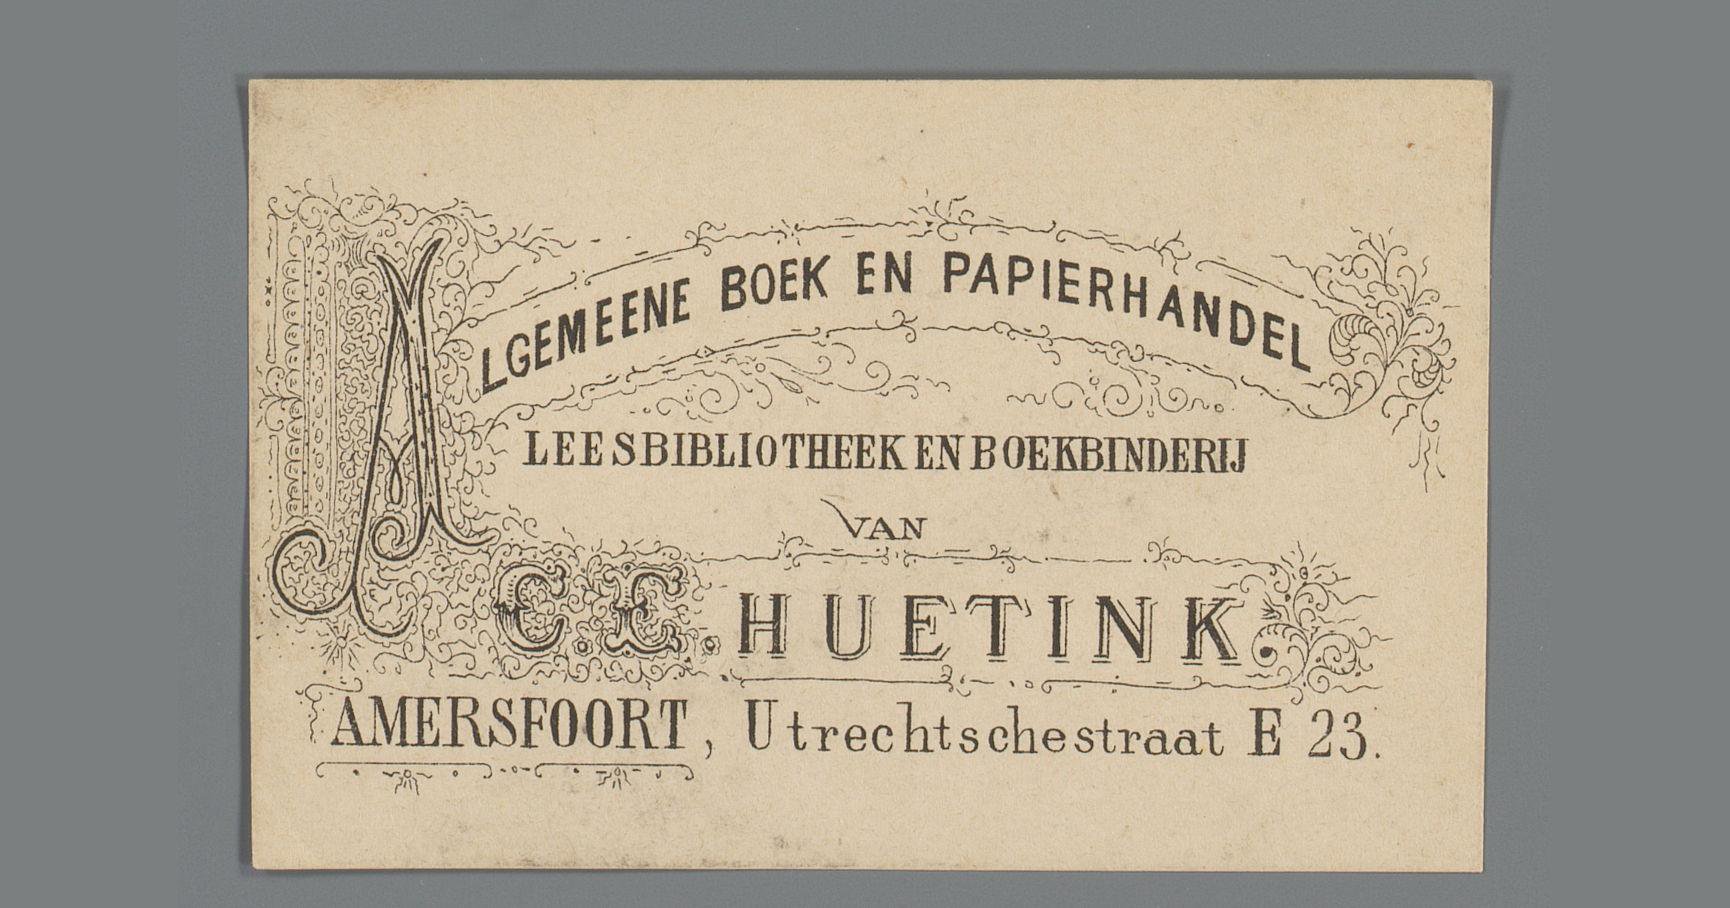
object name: photomechanical print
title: Adreskaart van boek- en papierhandel, leesbibliotheek en boekbinderij C.E. Huetink in Amersfoort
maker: Anonymous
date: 1830-1900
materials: paper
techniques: printing block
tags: initial, printed matter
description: Typografische kaart met middeleeuws aandoende penwerk decoratie rond de letters A, C en E.